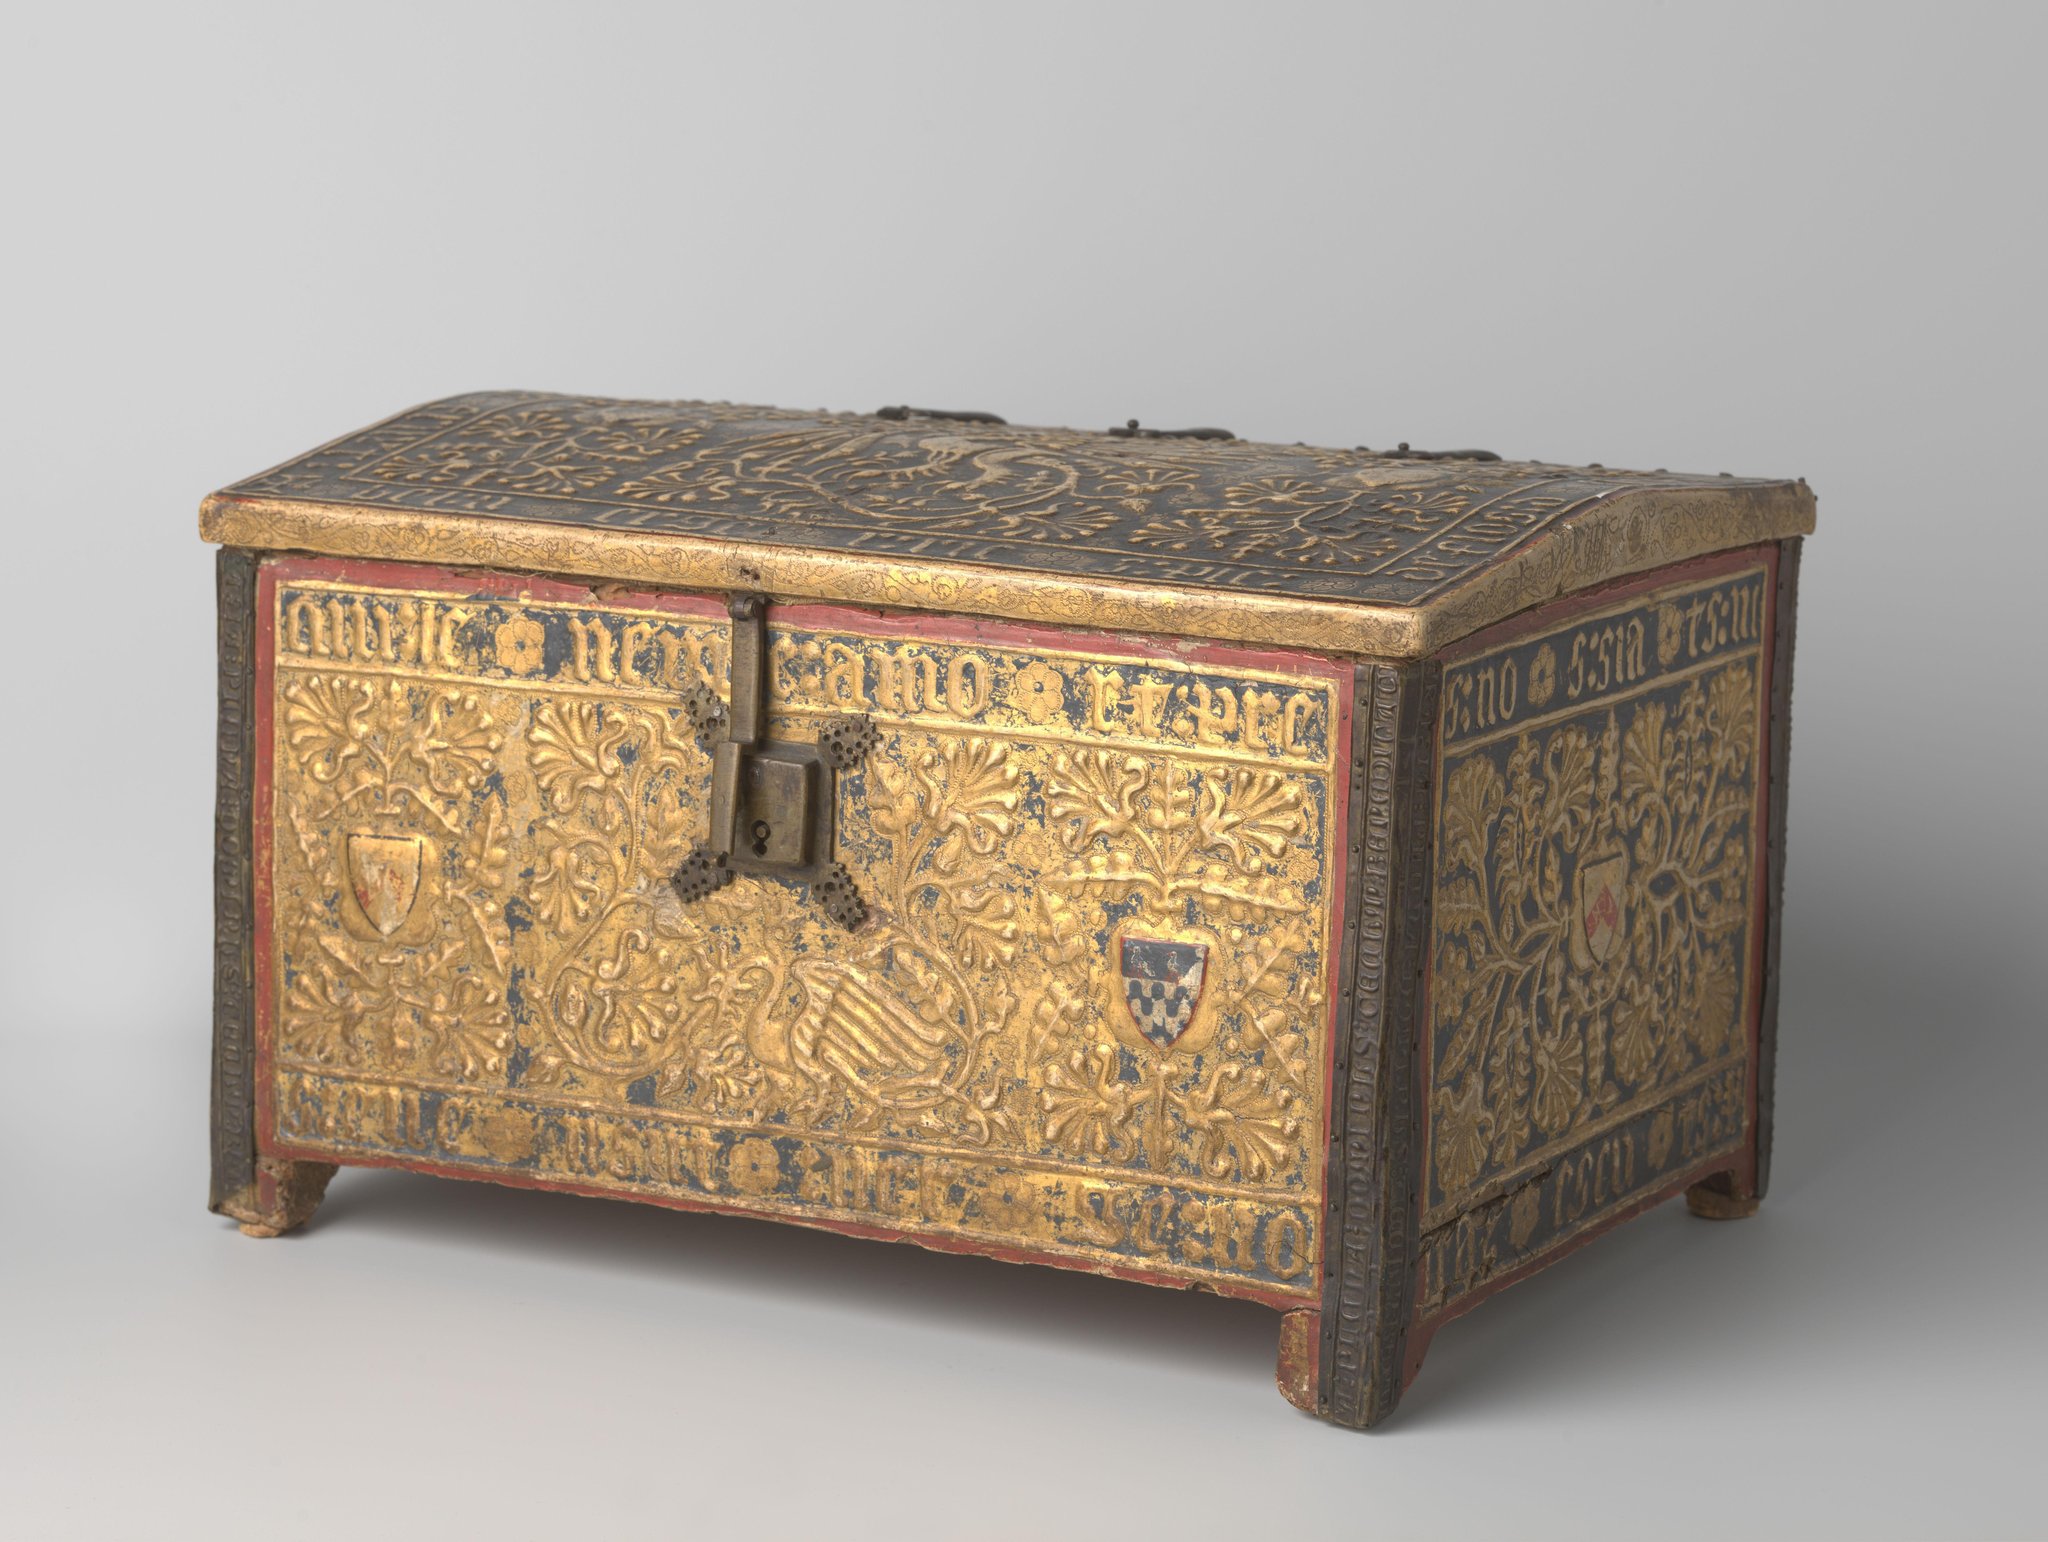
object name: case furniture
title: Kist van gepolychromeerd hout en versierd met verguld stucco in de vorm van wapenschilden met opschriften in het Latijn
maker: Anonymous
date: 1400-1500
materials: copper, wood, paint, plaster, textile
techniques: gilding, painted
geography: italy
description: Kleine kist van gepolychromeerd populierenhout, met versieringen in verguld stucco bestaande uit bladranken met aan de voorkant in het midden en op het deksel een draak geflankeerd door wapenschilden met opschriften in het Latijn. Aan de achterzijde vier staande velden met bladranken, waaronder opschriften. Het beslag op de hoeken dat gevormd wordt door dunne koperen platen toont eveneens opschriften. Het slot en de hengsels zijn van koper. De groene bekleding binnenin is gedeeltelijk versleten.